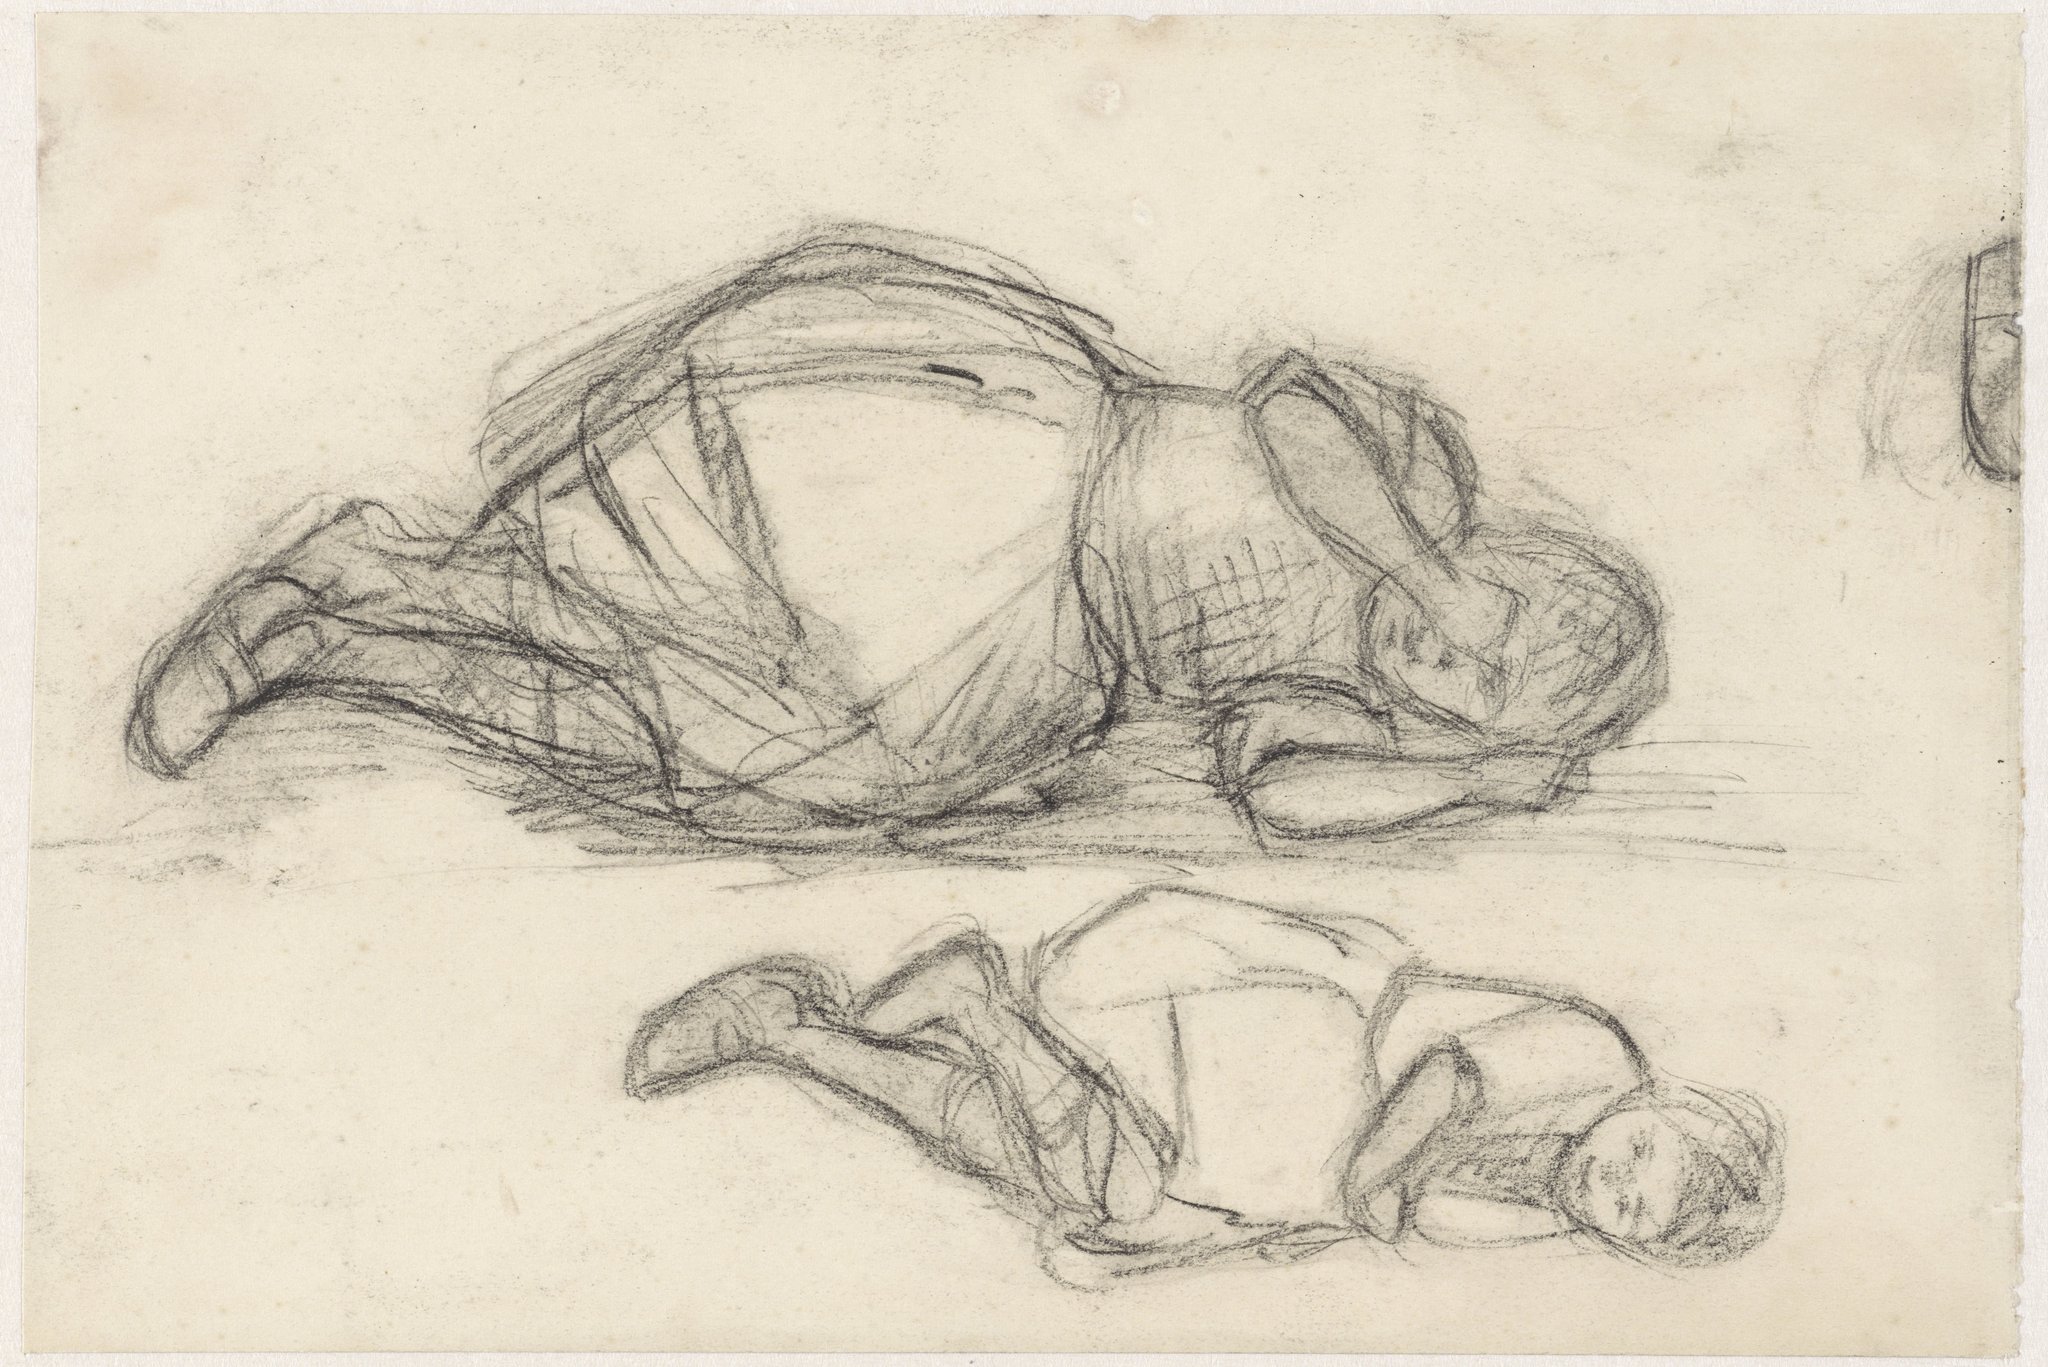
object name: drawing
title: Twee studies van een liggend meisje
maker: jozef israëls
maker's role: draughtsman, painter, print maker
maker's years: 1824-1911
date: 1834-1911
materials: chalk, paper